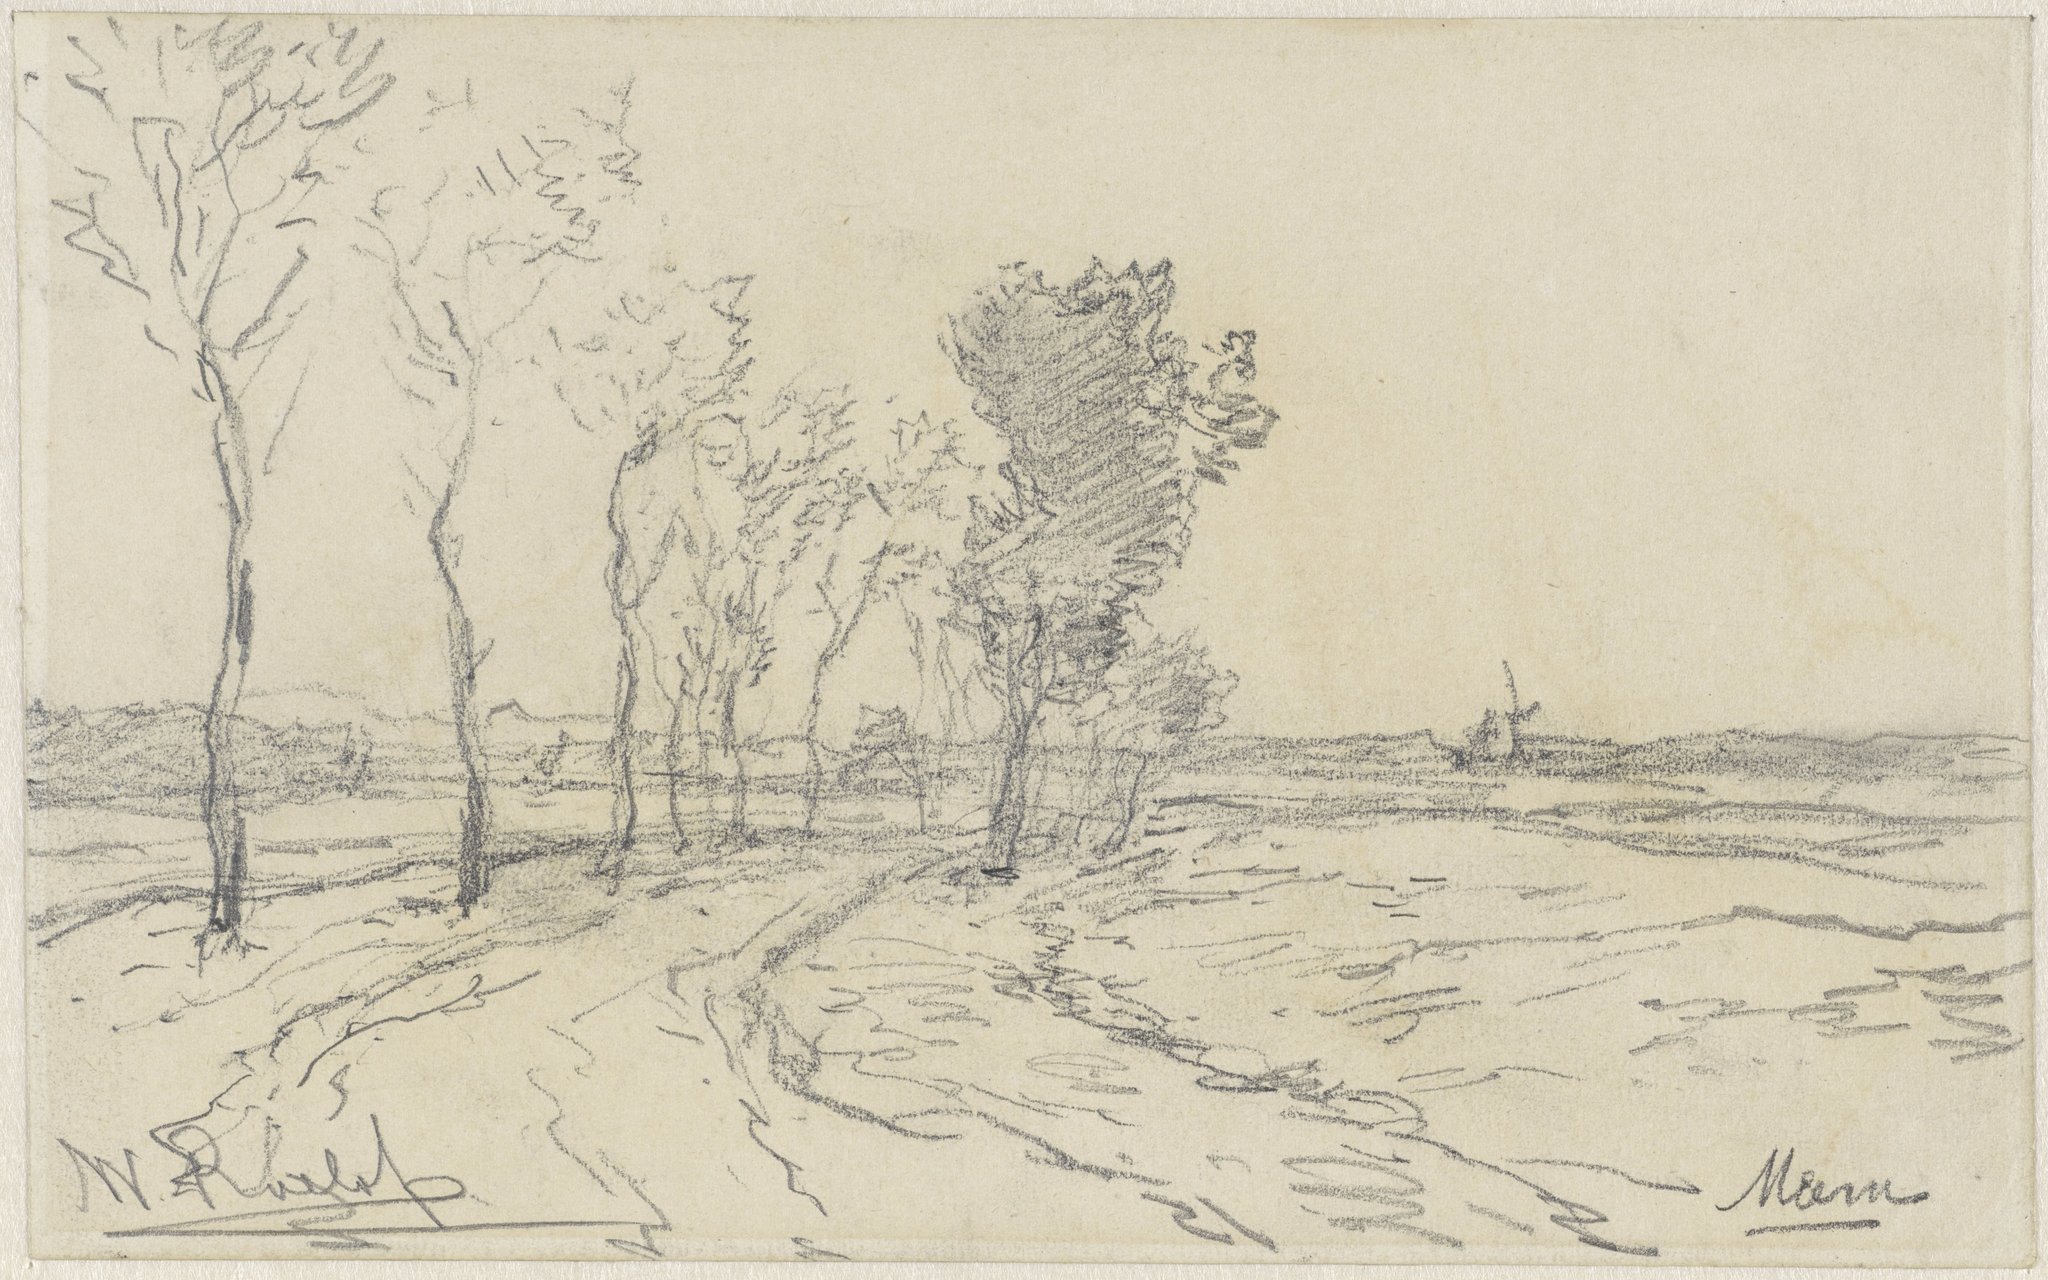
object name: drawing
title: Landschap met laan, met aan weerzijde bomen te Meern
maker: willem roelofs (i)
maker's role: draughtsman, painter, print maker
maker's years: 1822-1897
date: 1832-1897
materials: paper, pencil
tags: plain